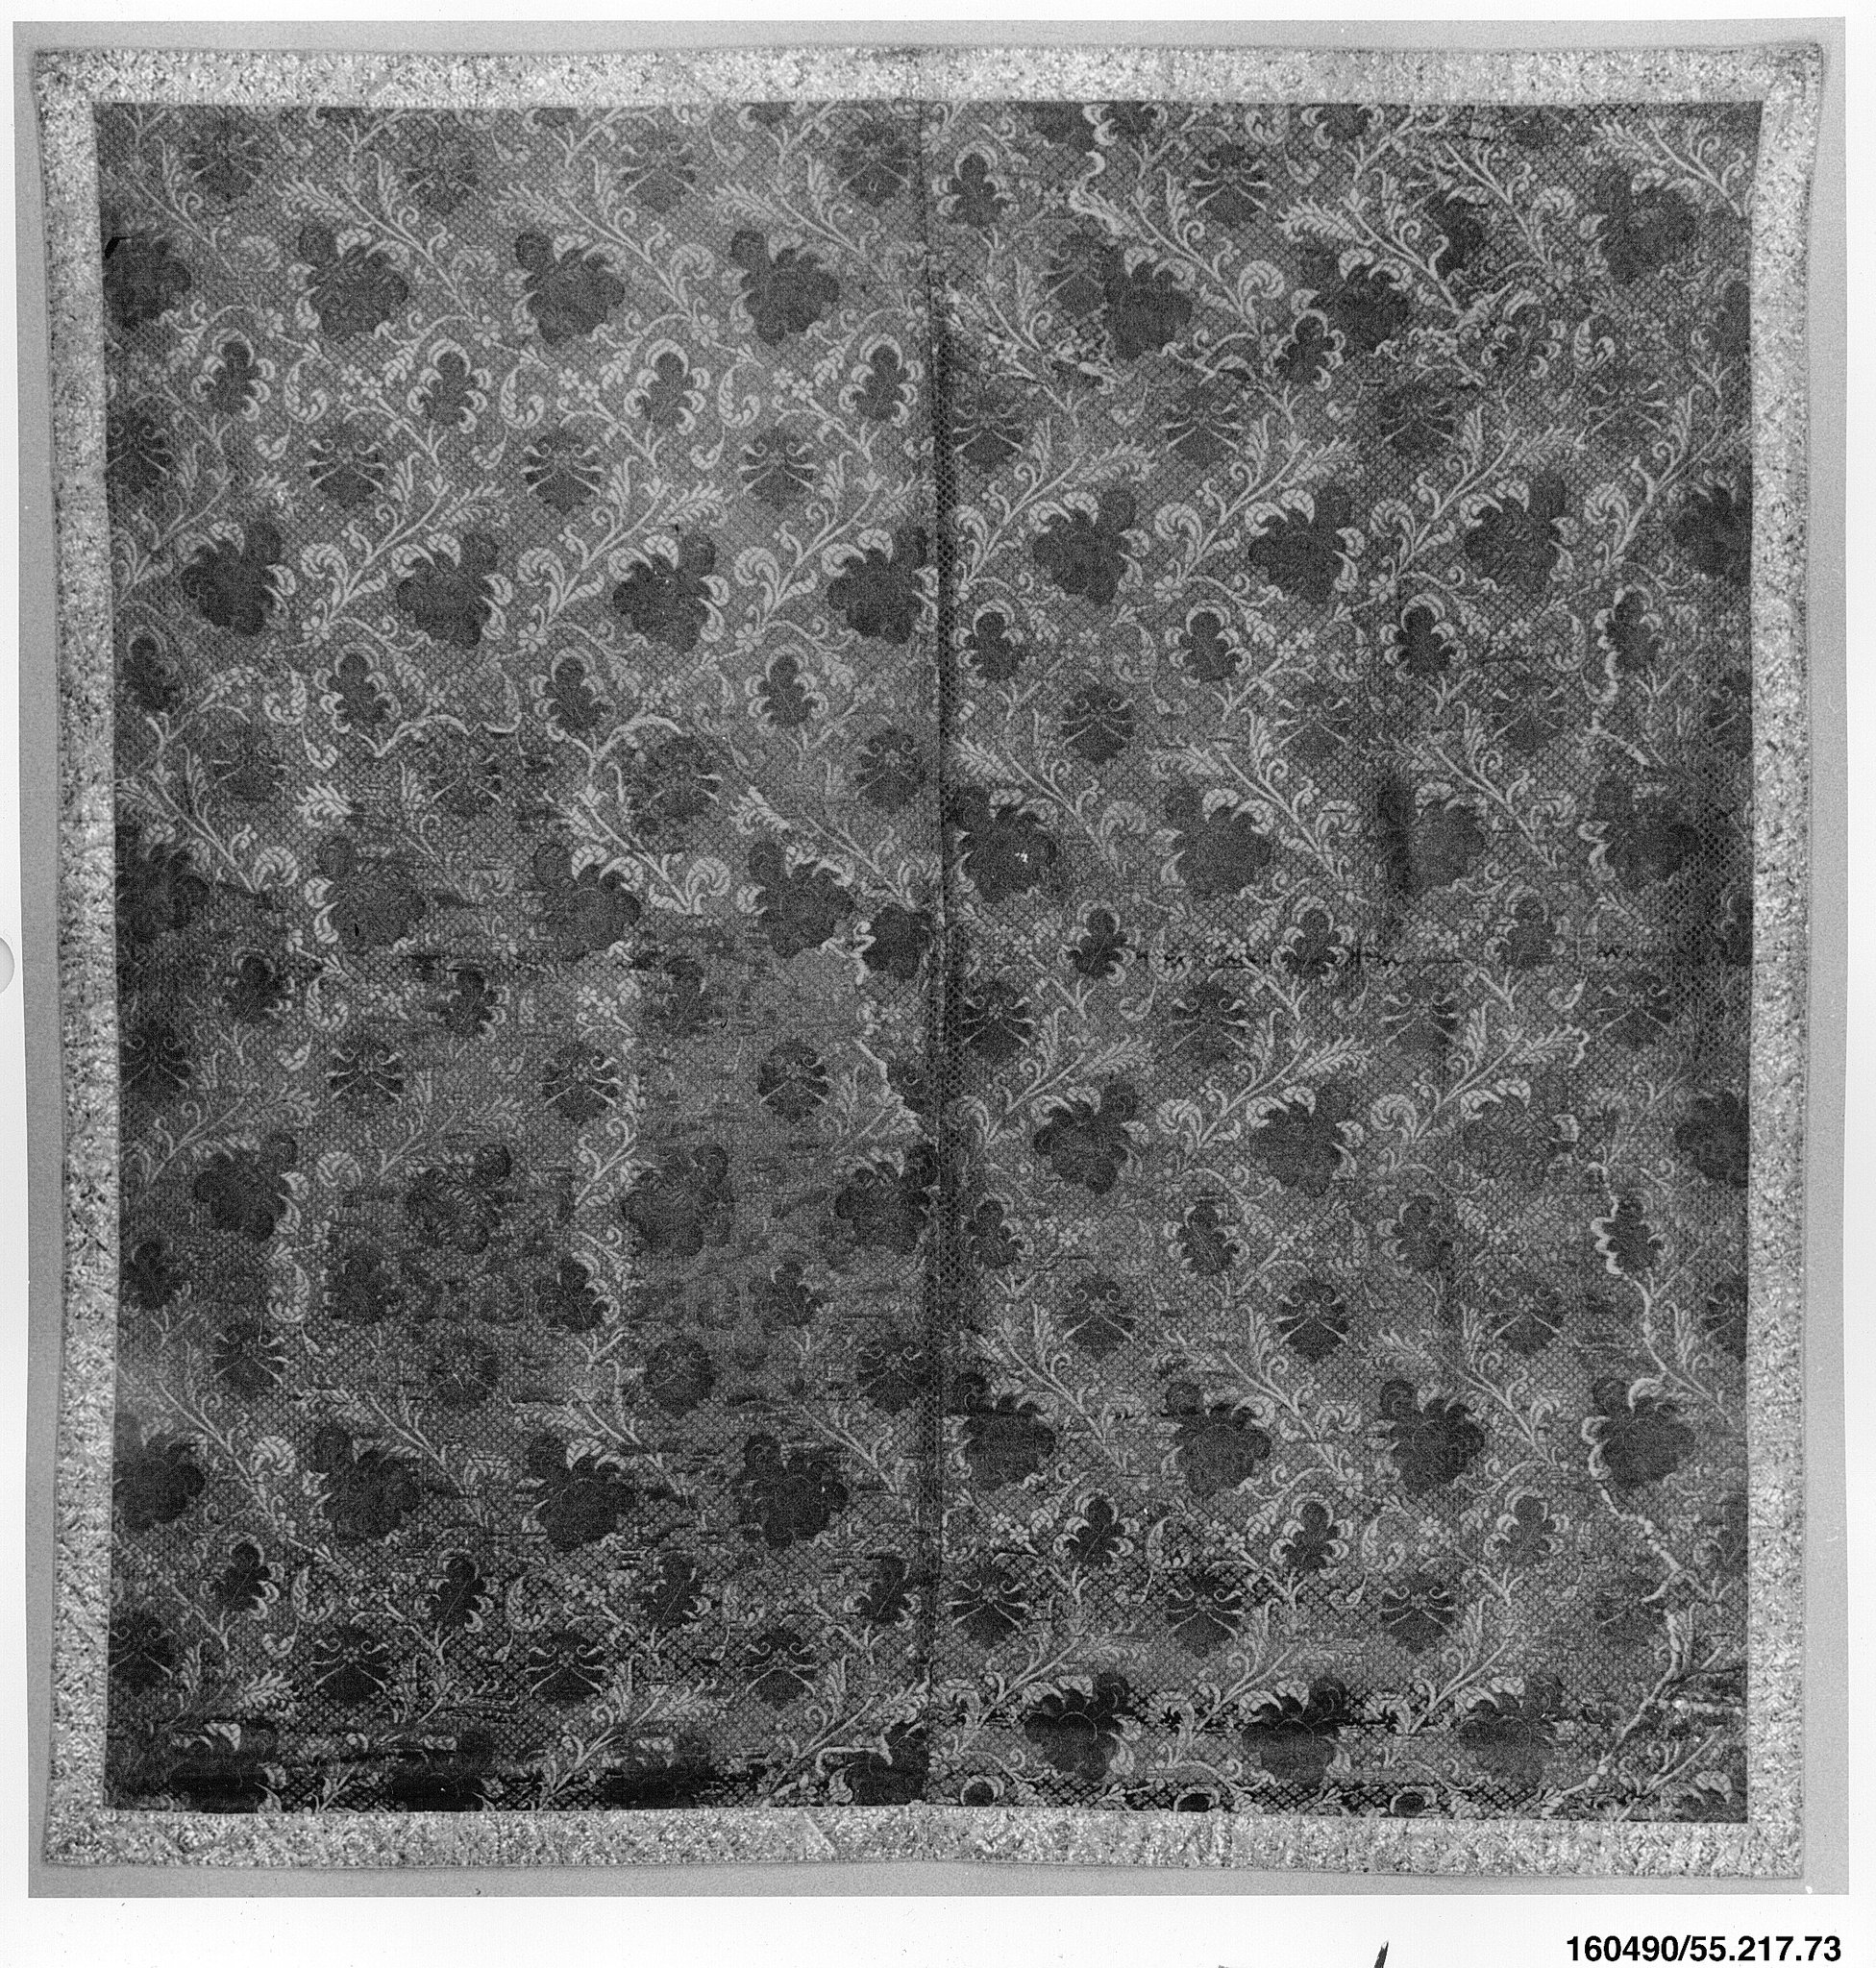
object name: piece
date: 1751-1775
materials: metal thread, silk